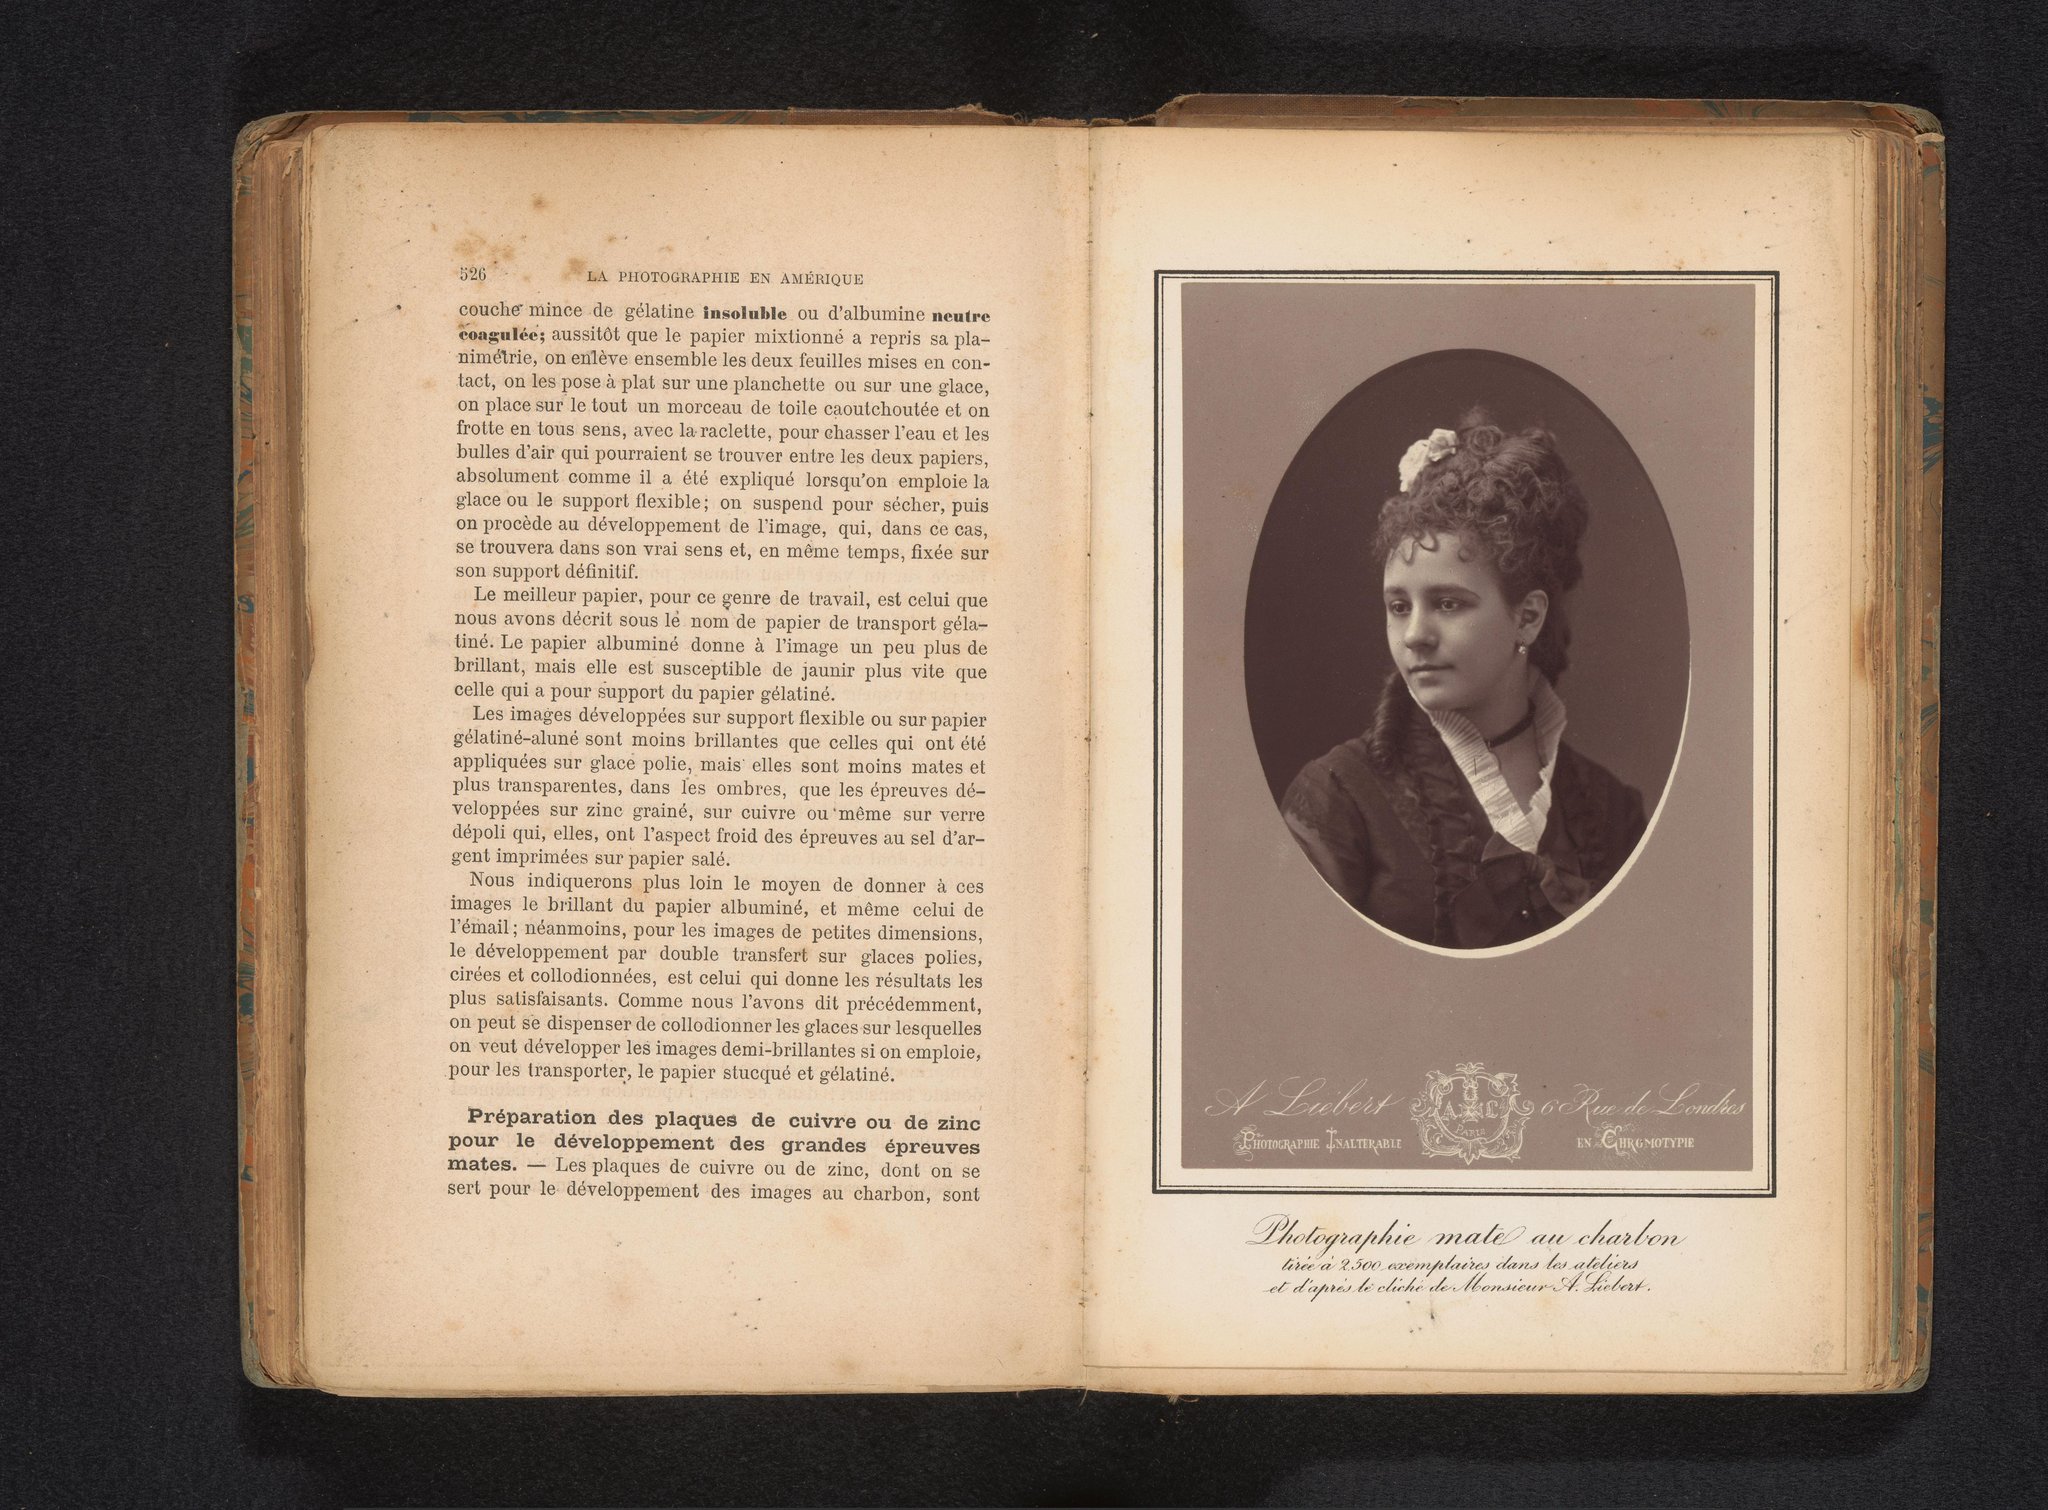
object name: page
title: Portret van een onbekende vrouw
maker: alphonse-justin liébert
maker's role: fotograaf, marinier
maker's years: 1827-1914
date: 1873-1878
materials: paper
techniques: carbon print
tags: historical persons not known by name - bb - woman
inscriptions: inscription: ‘Photographies mate au charbon/ tirée à 2.500 exemplaires dans les ateliers/ et d'après le cliché de Monsieur A. Liébert.’, inscription: ‘A. Liébert 6 Rue de Londres/ Paris/ Photographie Inalterable en Chromotypie’